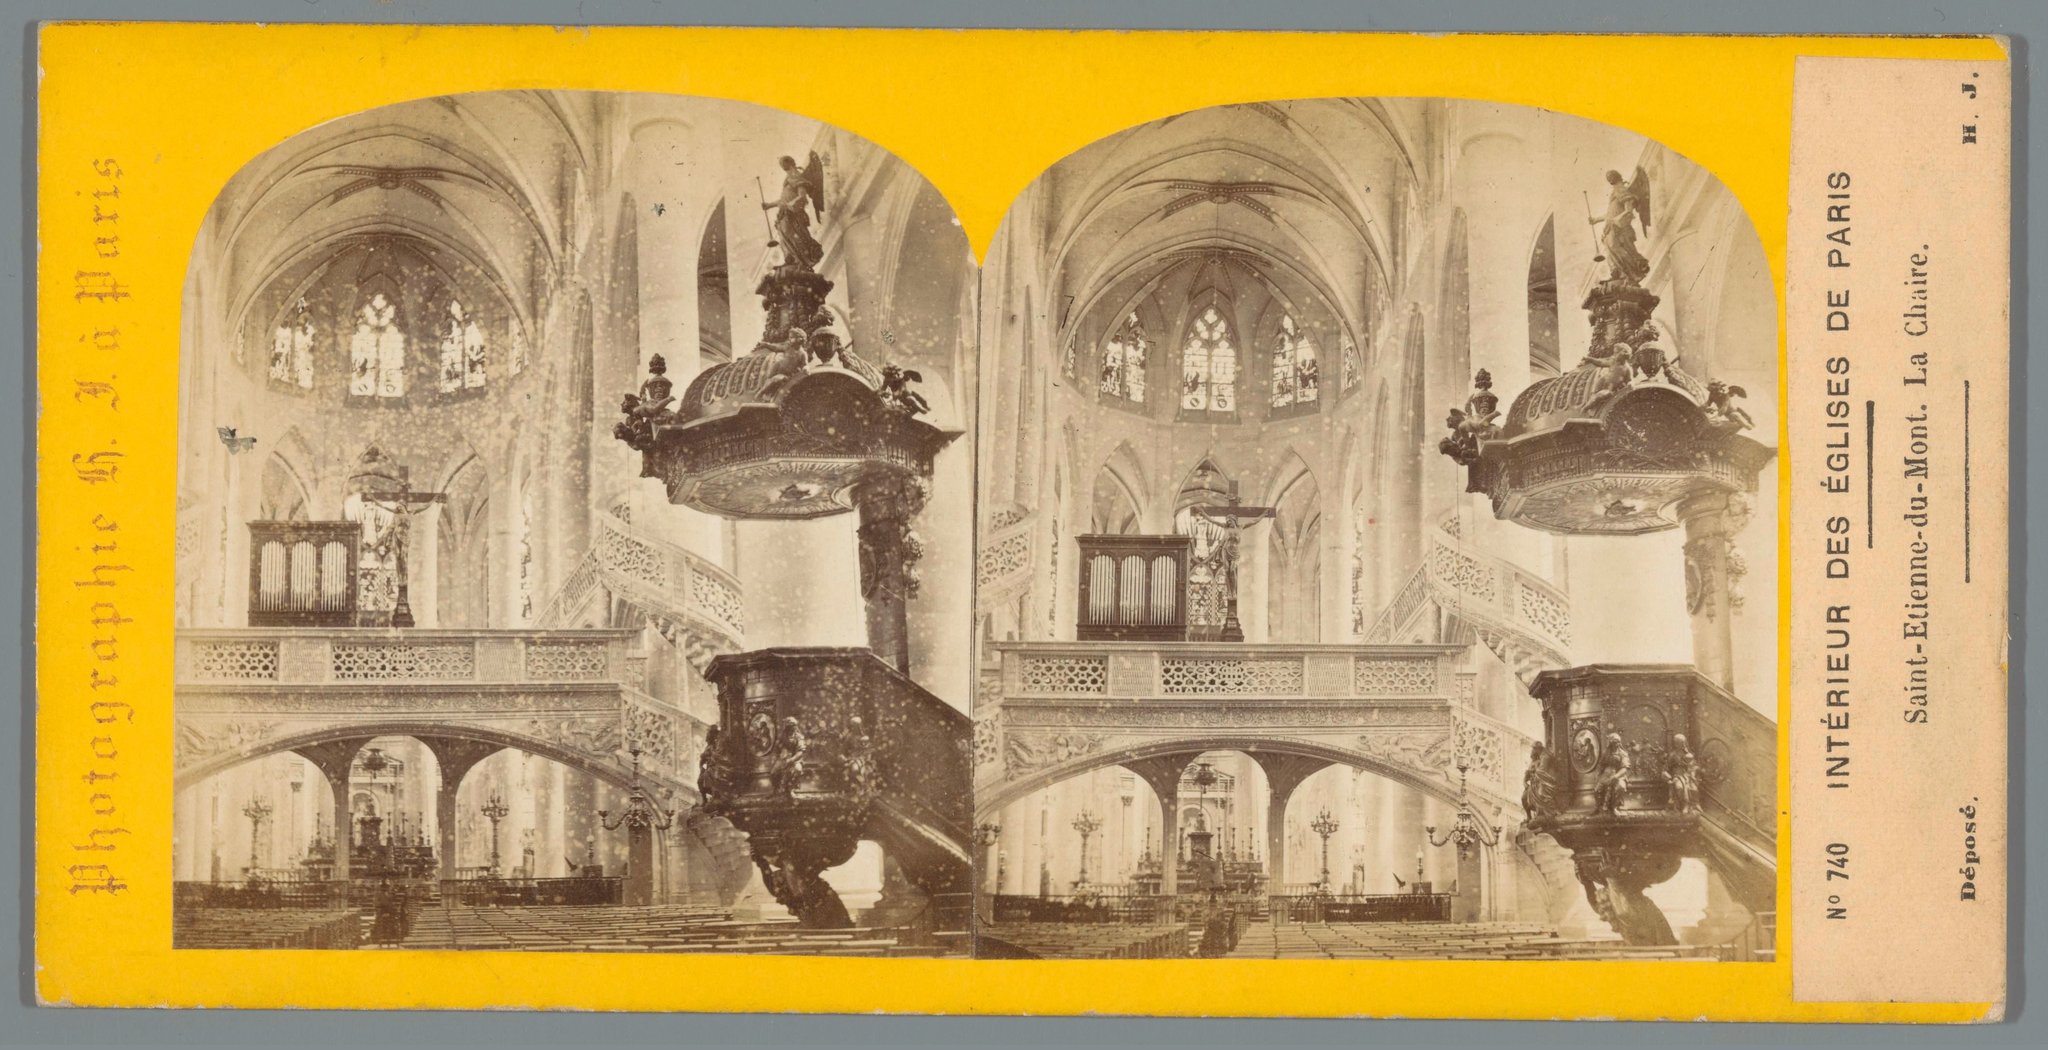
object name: stereograph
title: Intérieur des églises de Paris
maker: hippolyte jouvin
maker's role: fotograaf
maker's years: 1825-1889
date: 1850-1880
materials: cardboard, photographic support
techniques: albumen print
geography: saint-etienne-du-mont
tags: interior of church, pulpit, ambo, chancel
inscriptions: number: ‘No 740’